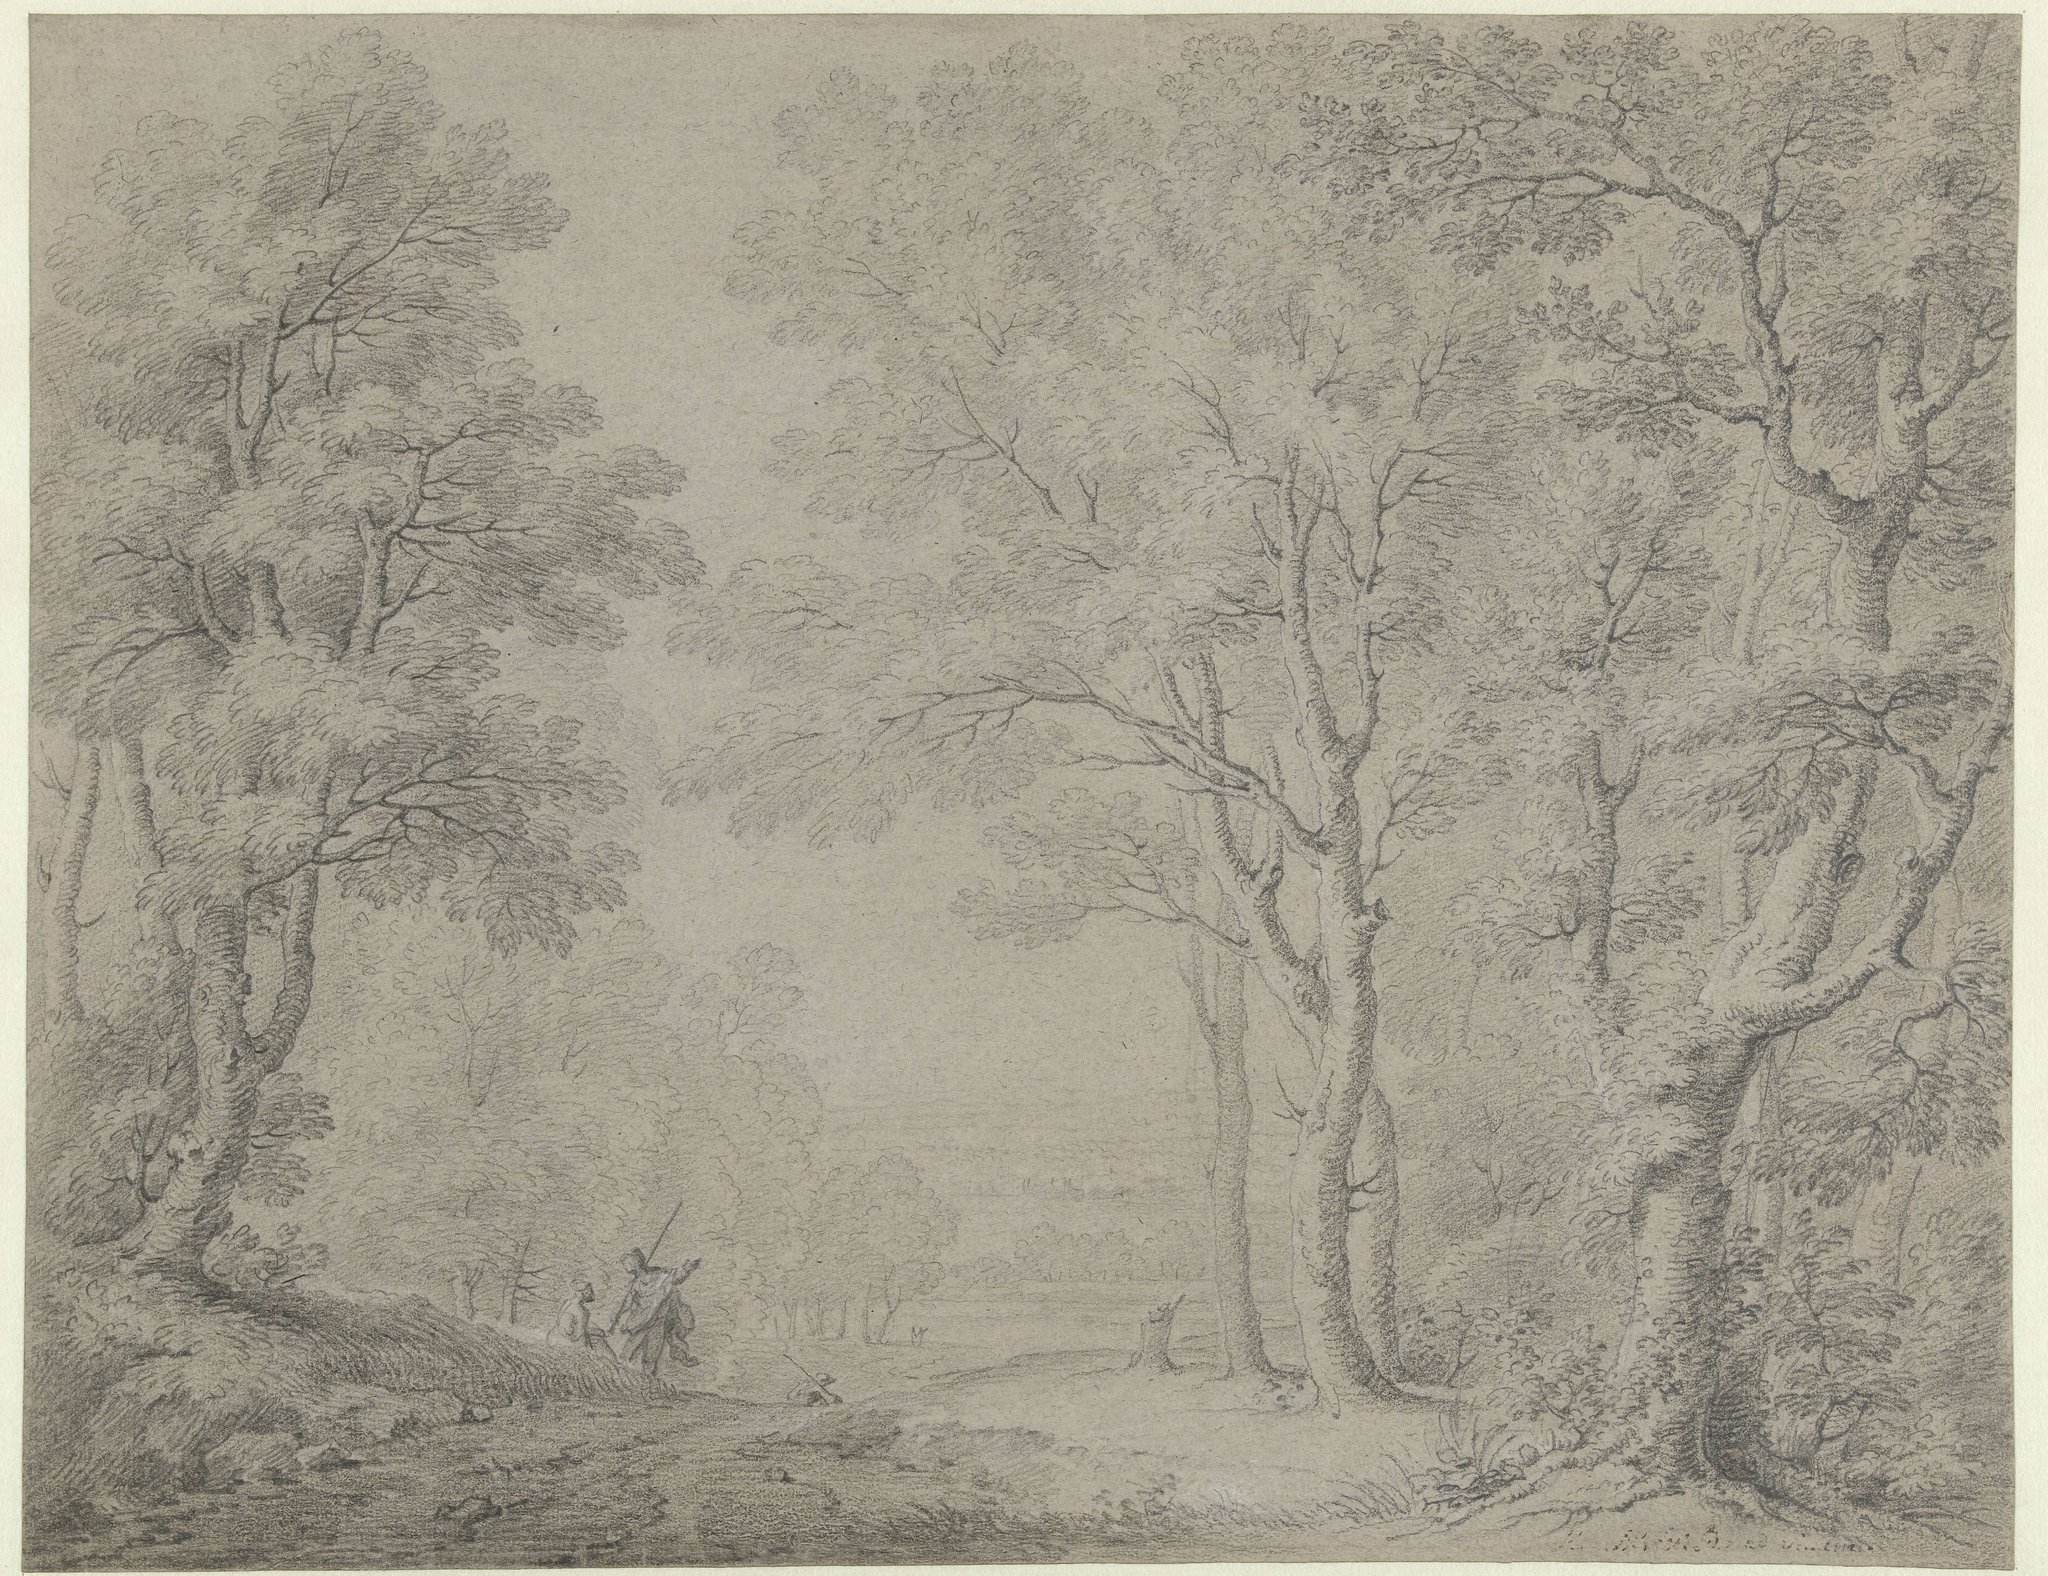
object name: drawing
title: Bosgezicht met figuren op de voorgrond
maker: Anonymous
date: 1650-1700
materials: chalk, paper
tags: forest, wood